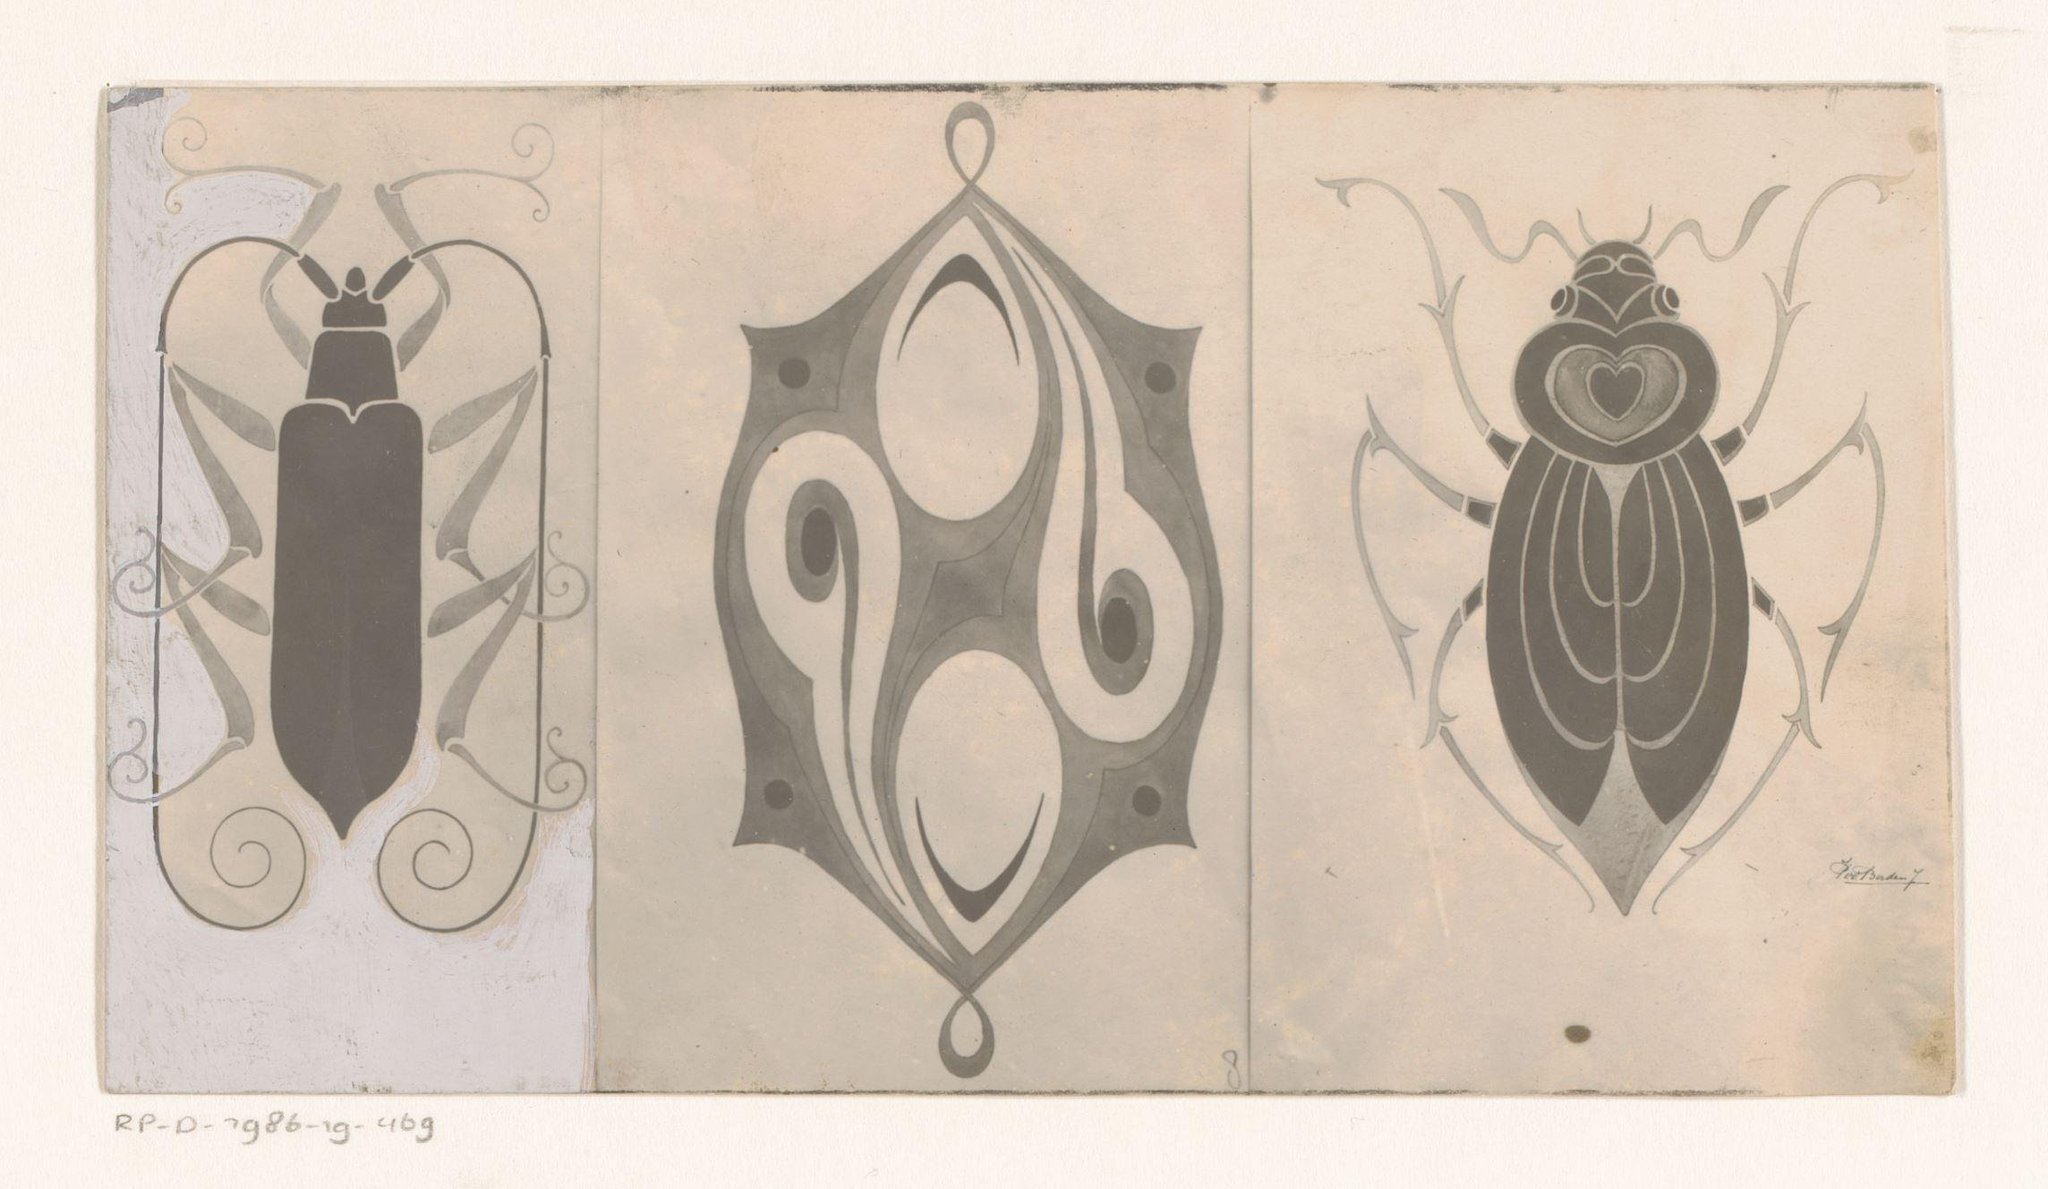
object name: photograph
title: Fotoreproductie van ornamenten, waarvan twee met insecten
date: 1910-1986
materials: paint, photographic support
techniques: brush, gelatin silver print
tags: ornaments ~ art, insects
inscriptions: number: ‘7775’, collector's mark: ‘R:MVS.’, annotation: ‘R[...]y’